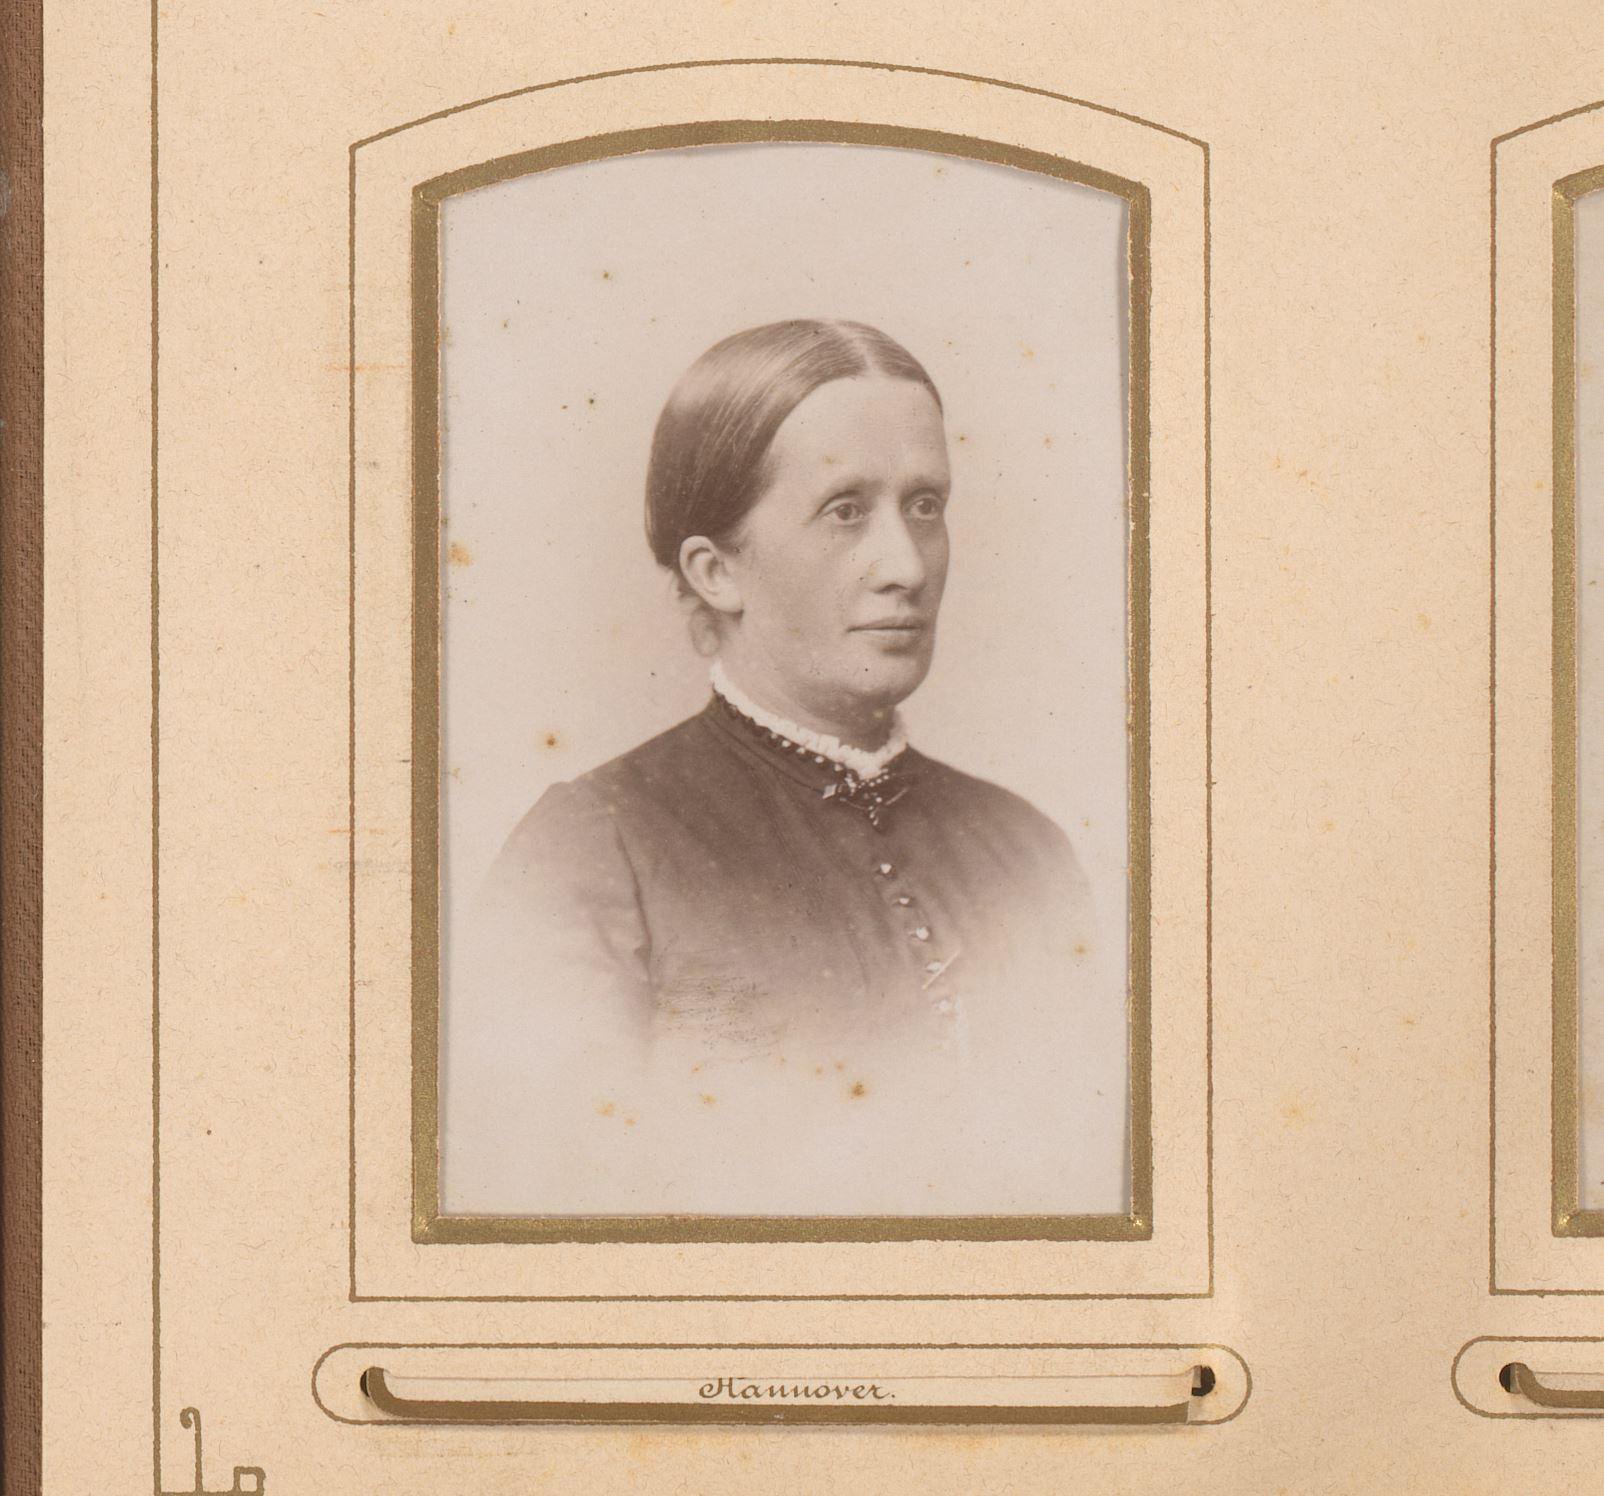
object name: carte de visite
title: Portret van een vrouw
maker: karl friedrich wunder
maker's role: fotograaf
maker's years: 1849-1924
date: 1870-1900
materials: cardboard, photographic support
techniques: albumen print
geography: hannover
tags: historical persons - bb - woman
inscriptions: inscription: ‘Karl F. Wunder/ Hannover/ Friedrichstrasse’